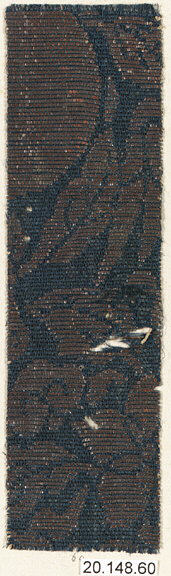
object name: piece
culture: japanese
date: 1401-1500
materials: silk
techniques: compound weave